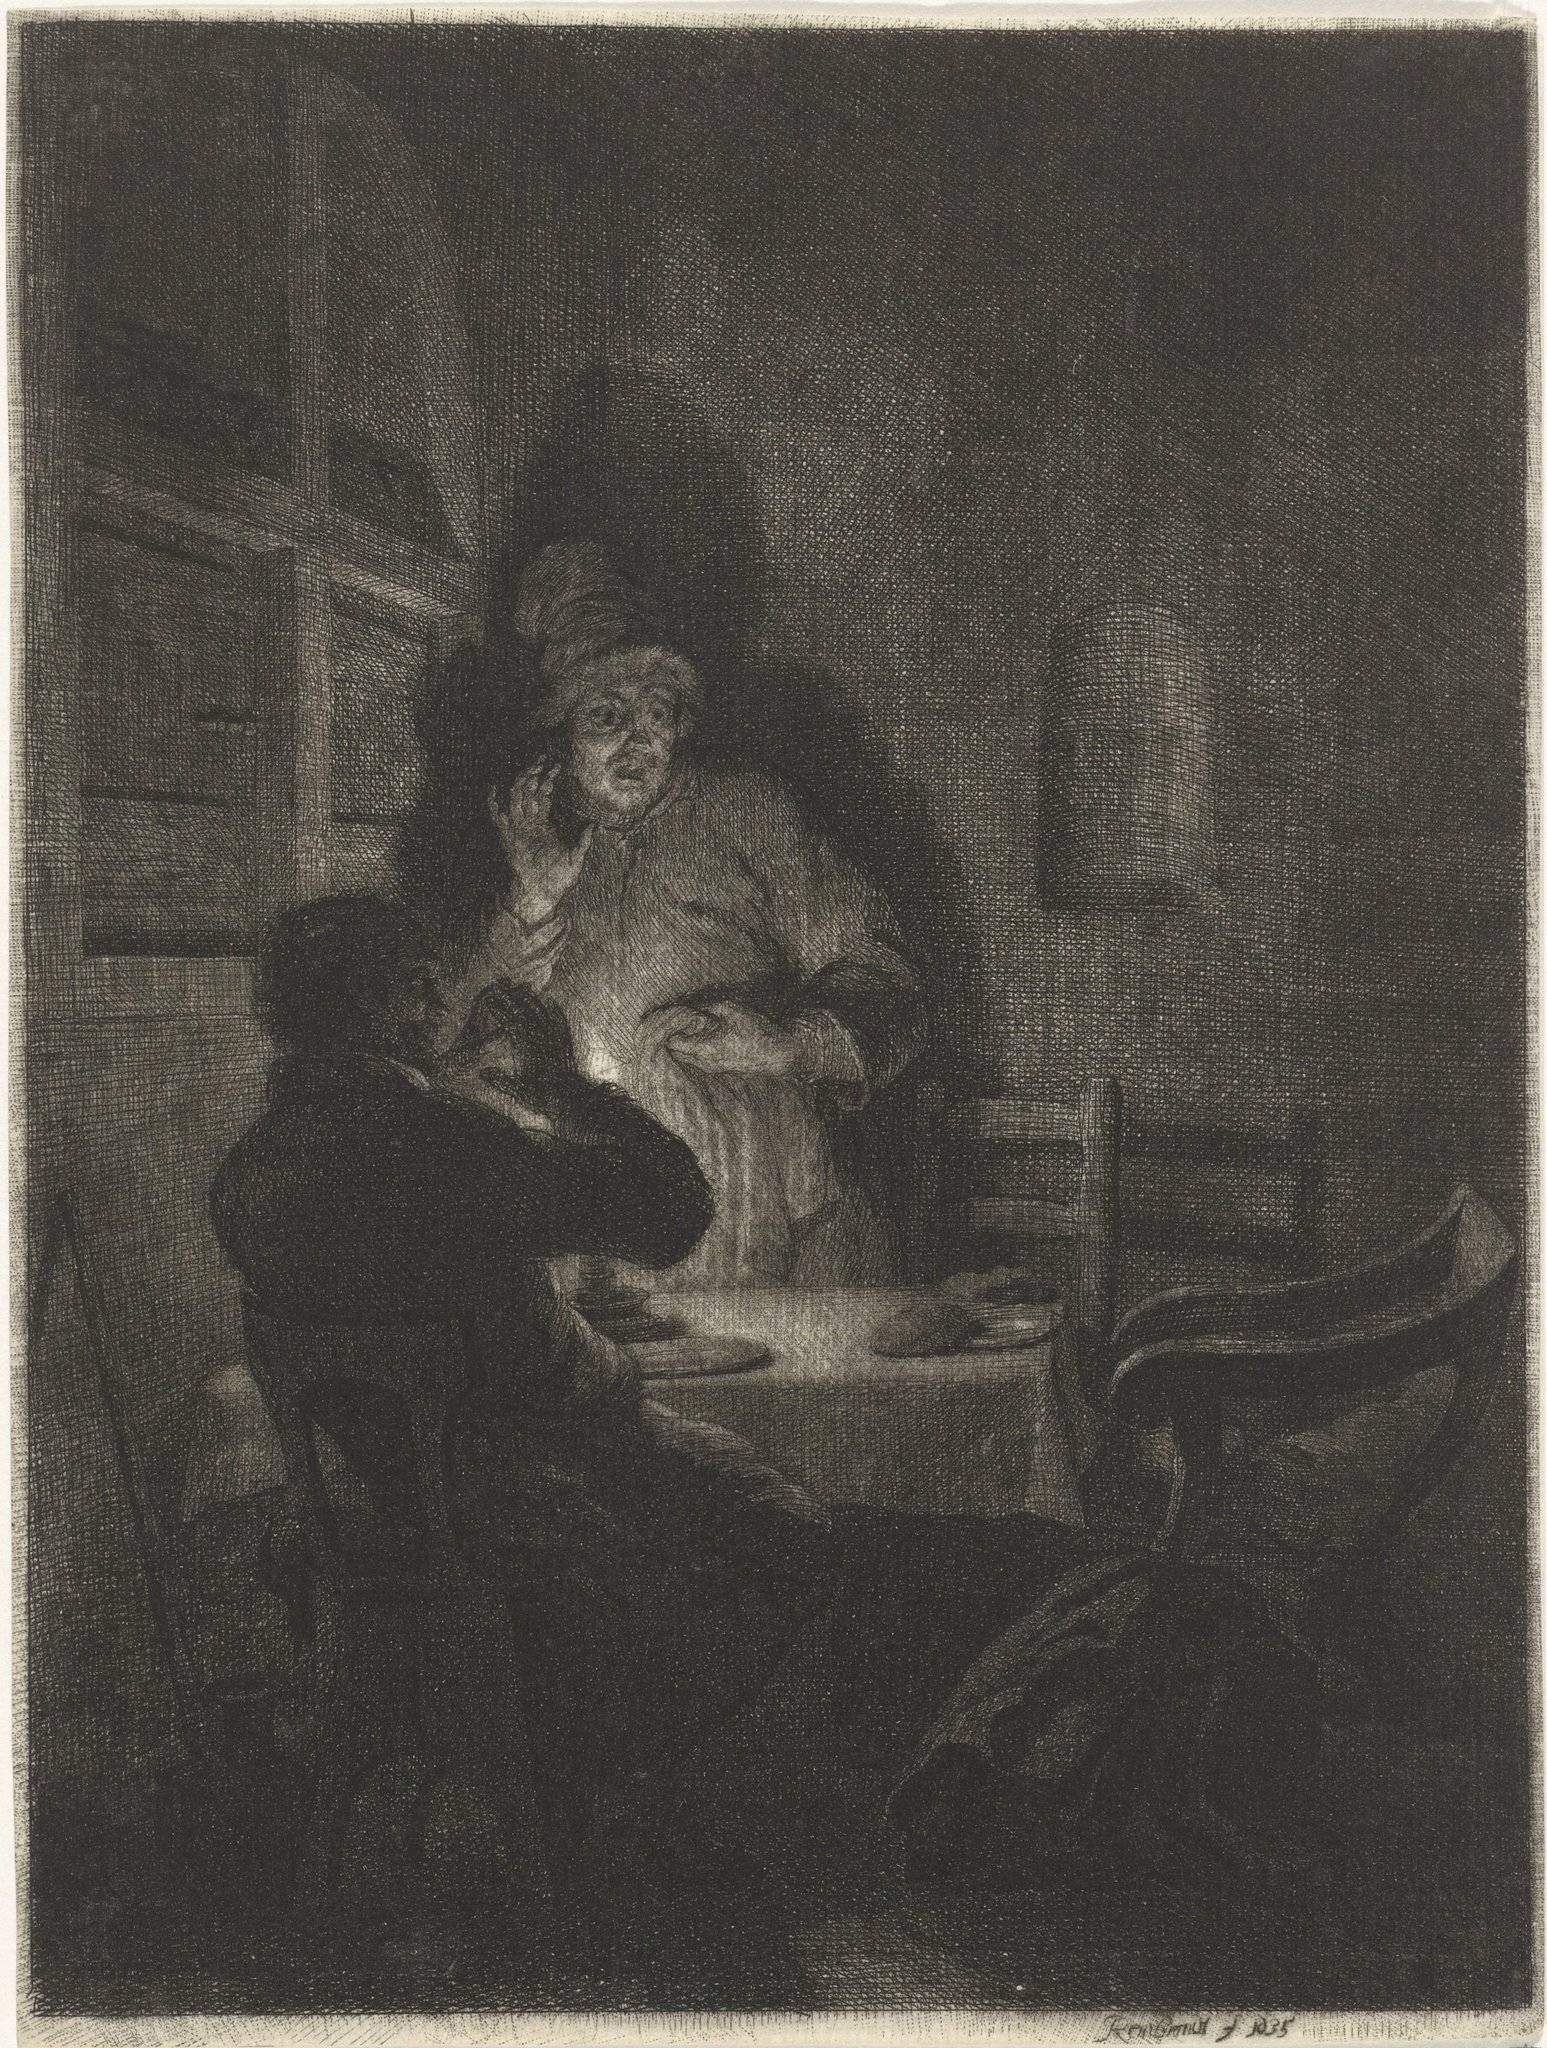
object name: print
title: Maaltijd in Emmaüs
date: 1670-1719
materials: paper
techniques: engraving, etching, roulette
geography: northern netherlands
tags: christ vanishes ~ supper at emmaus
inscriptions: collector's mark: Lugt 240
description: De twee discipelen uit het verhaal van de Emmaüsgangers in een interieur, beschenen door kaarslicht, aan een tafel waarop een een stuk brood. Zij kijken verschrikt naar een derde lege stoel, waaruit zojuist Christus plotsklaps is verdwenen nadat Hij voor hen het brood had gebroken. Na deze handeling hadden de discipelen de hen tot dan toe nog onbekende reisgenoot als Christus herkend en verdween Hij plotseling voor hun ogen.